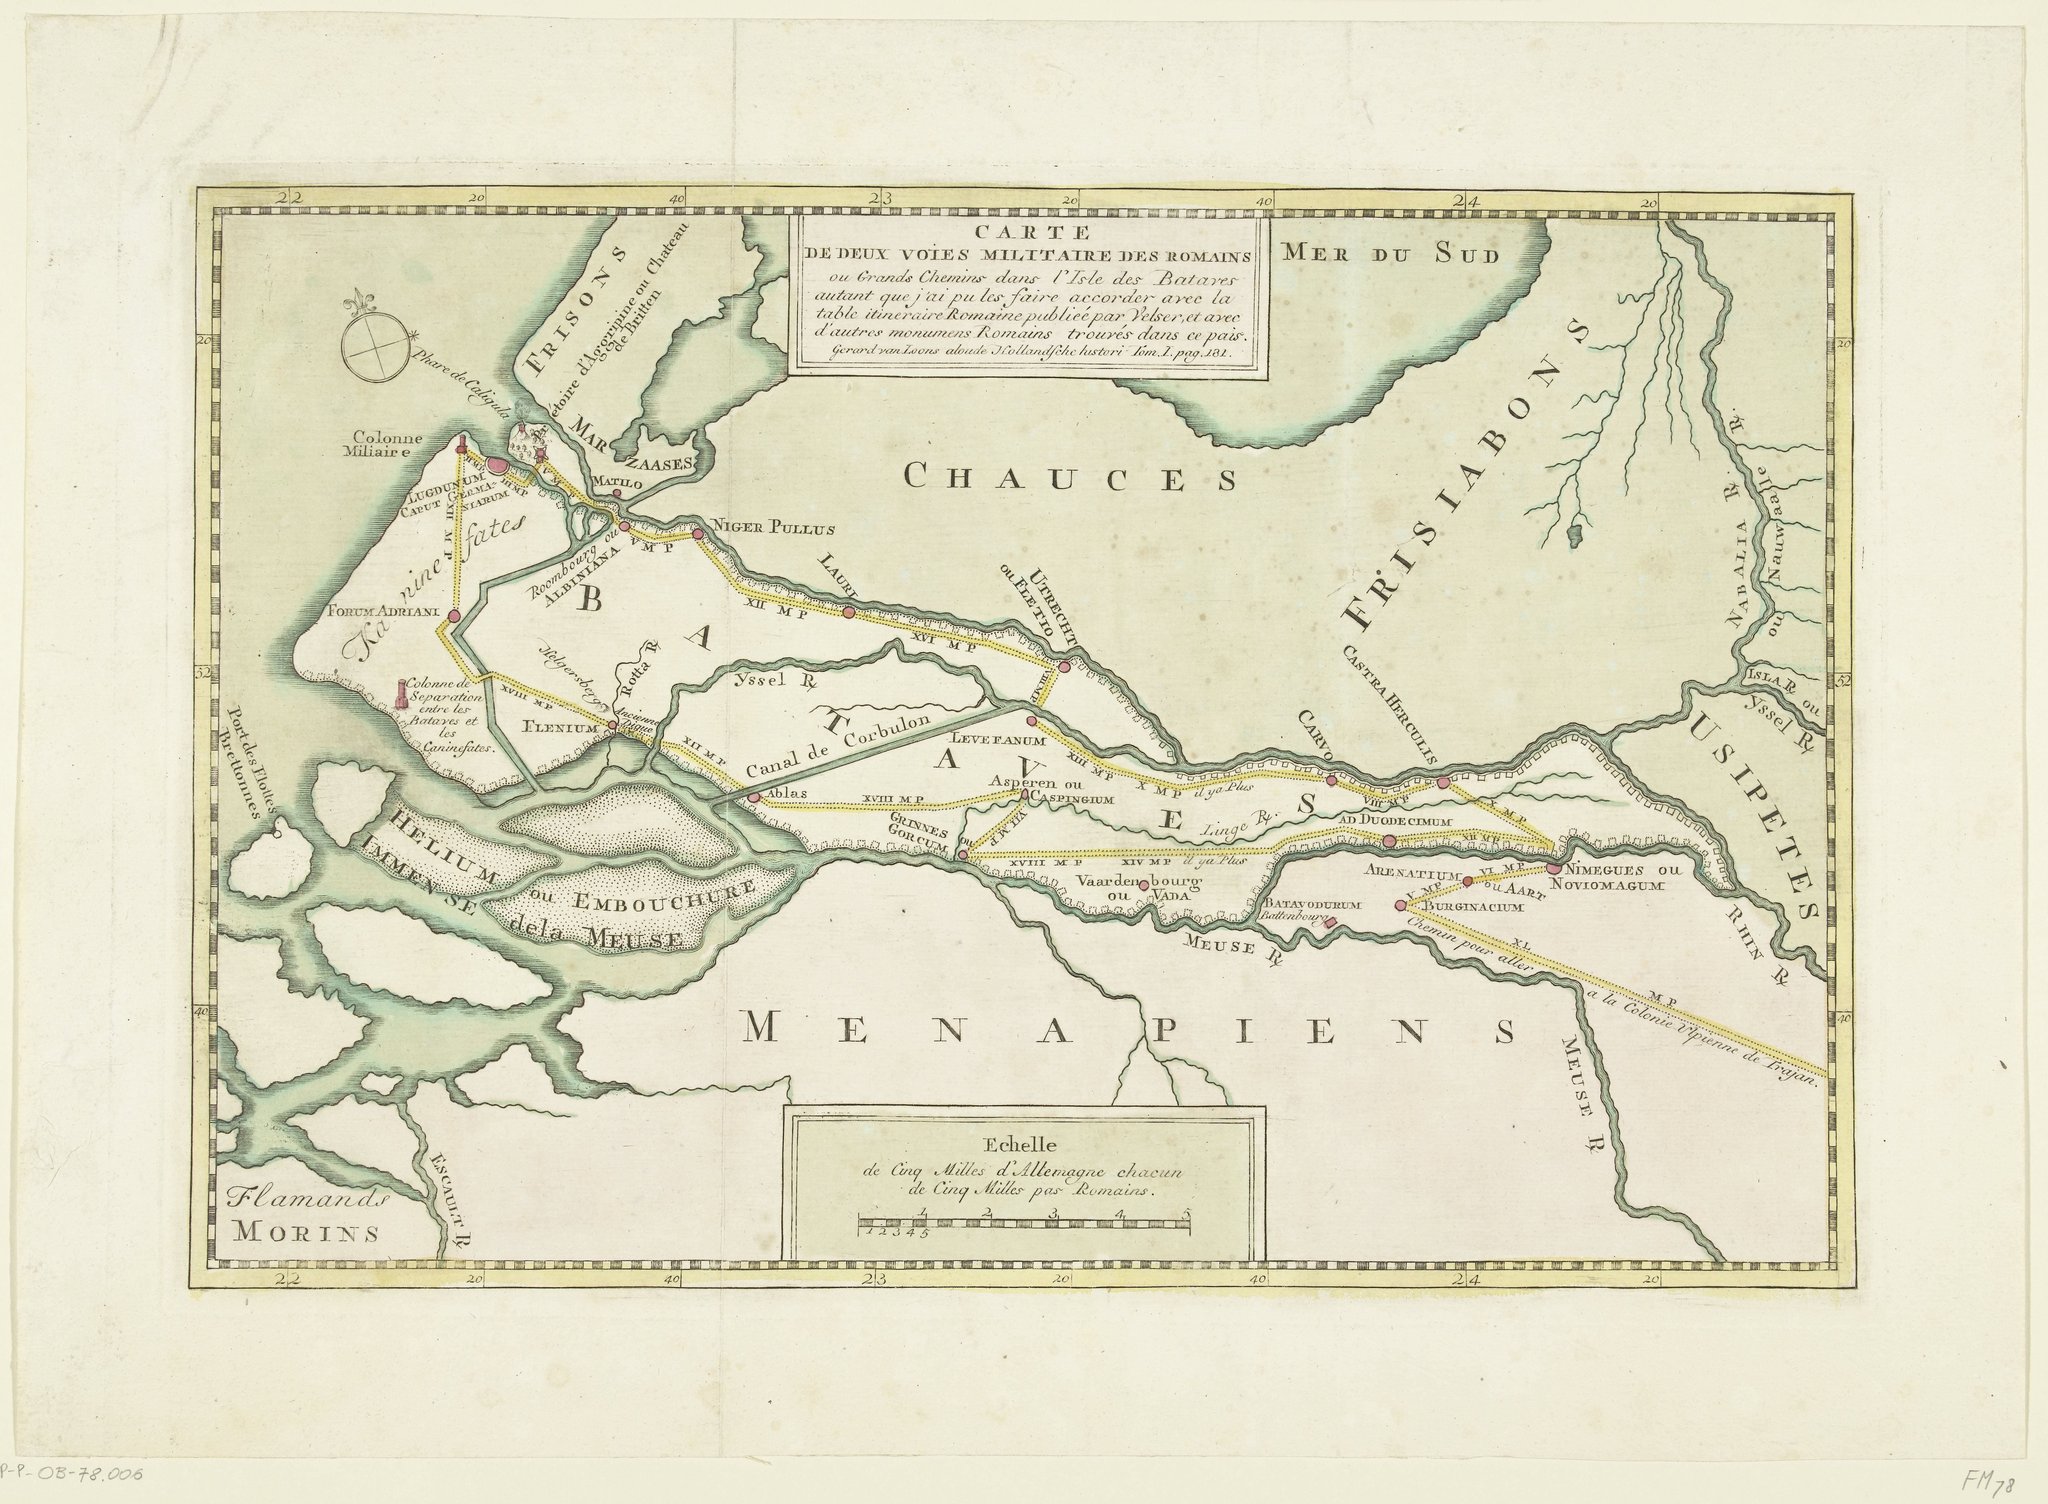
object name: print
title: Kaart van twee Romeinse militaire wegen in Nederland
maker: Anonymous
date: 1732-1734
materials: paper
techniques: engraving, etching, hand coloring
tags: road, path, netherlands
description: Illustratie voor: Gerard van Loons Aloude Hollandsche histori, Pieter de Hondt, ’s-Gravenhage 1734, 2 delen.